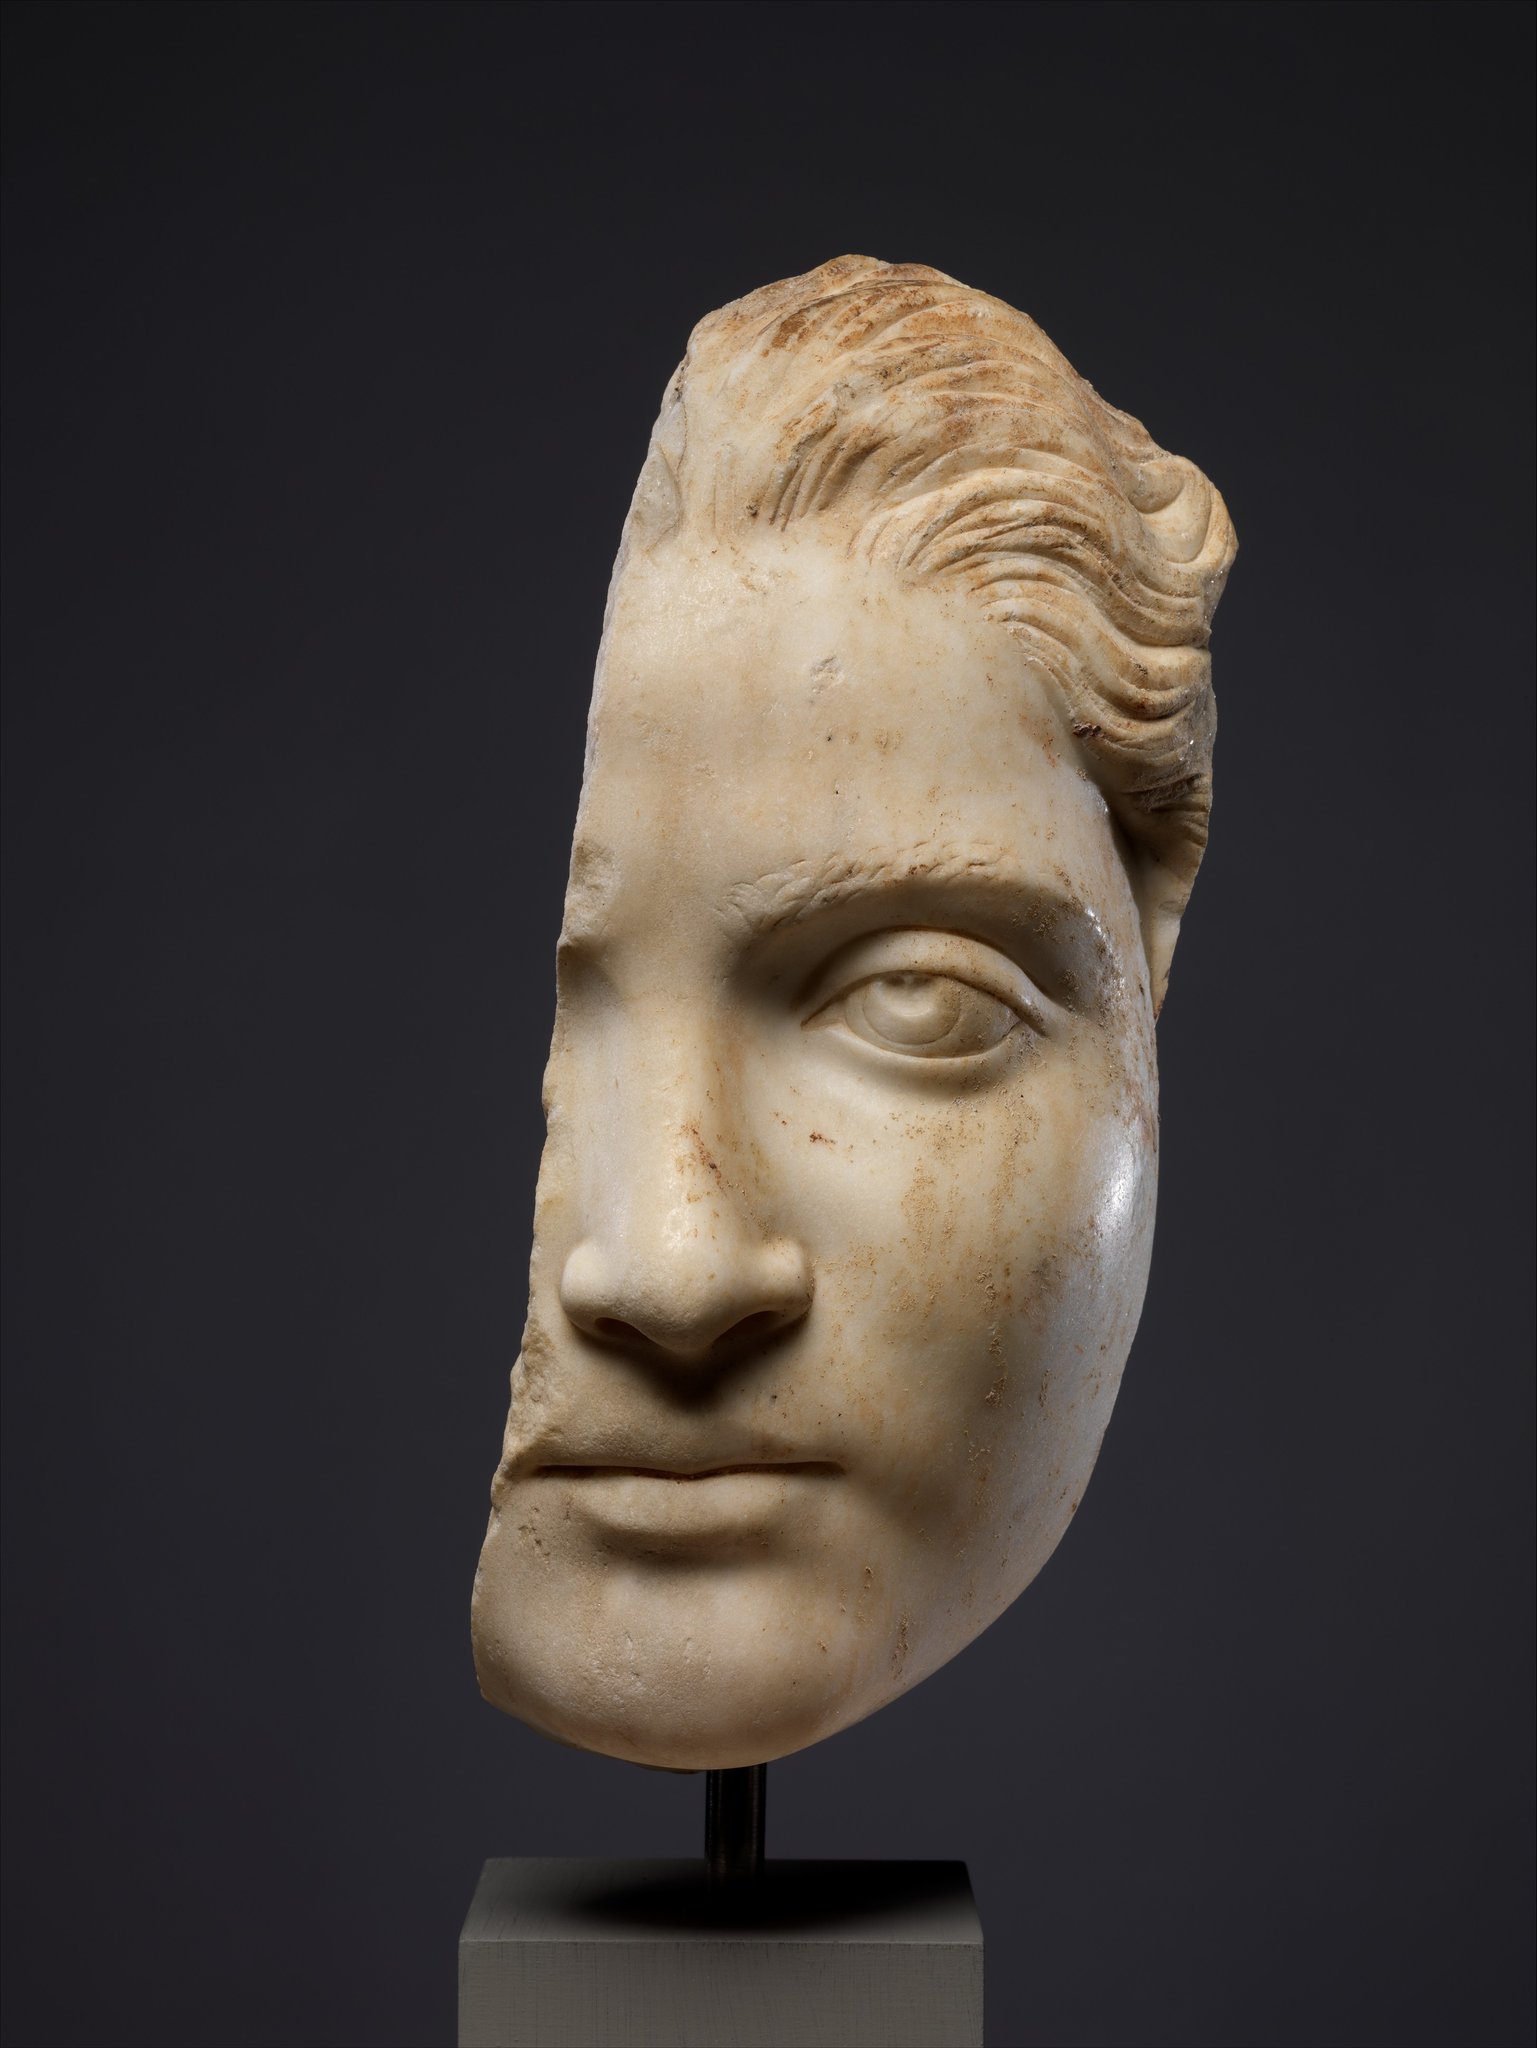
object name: portrait head of a woman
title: Fragmentary marble head of a girl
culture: roman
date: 138-161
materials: marble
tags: heads,portraits,women